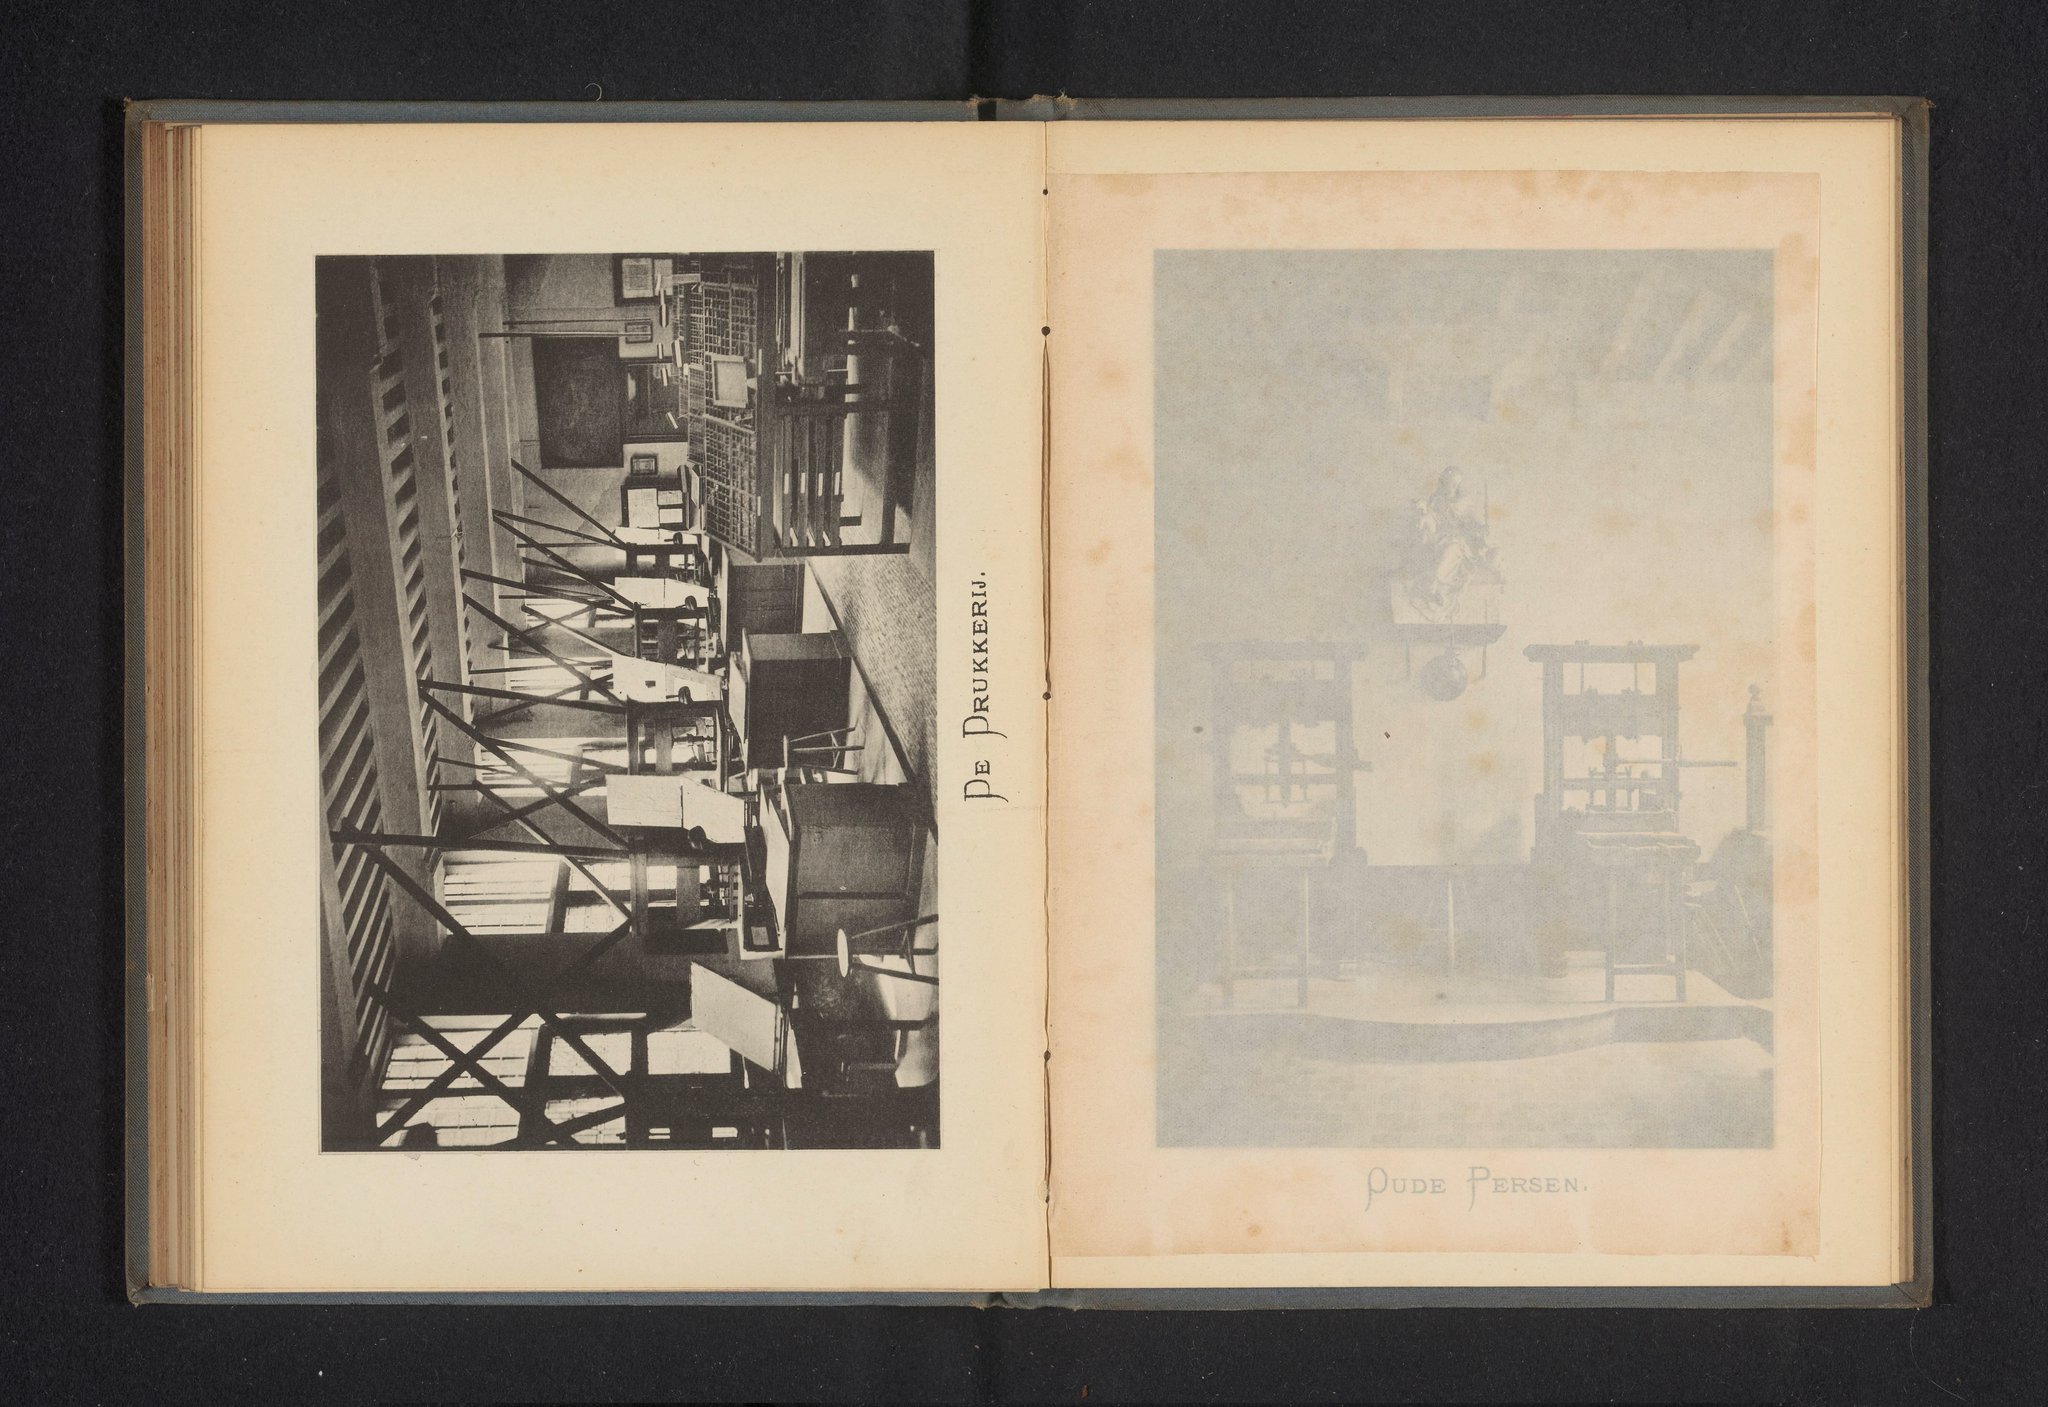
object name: page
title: Interieur van de drukkerij van Christoffel Plantijn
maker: joseph maes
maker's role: fotograaf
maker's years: 1838-1908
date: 1881-1886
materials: paper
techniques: photograph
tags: printing press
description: Prent op tweede ongenummerde pagina na pagina 128.